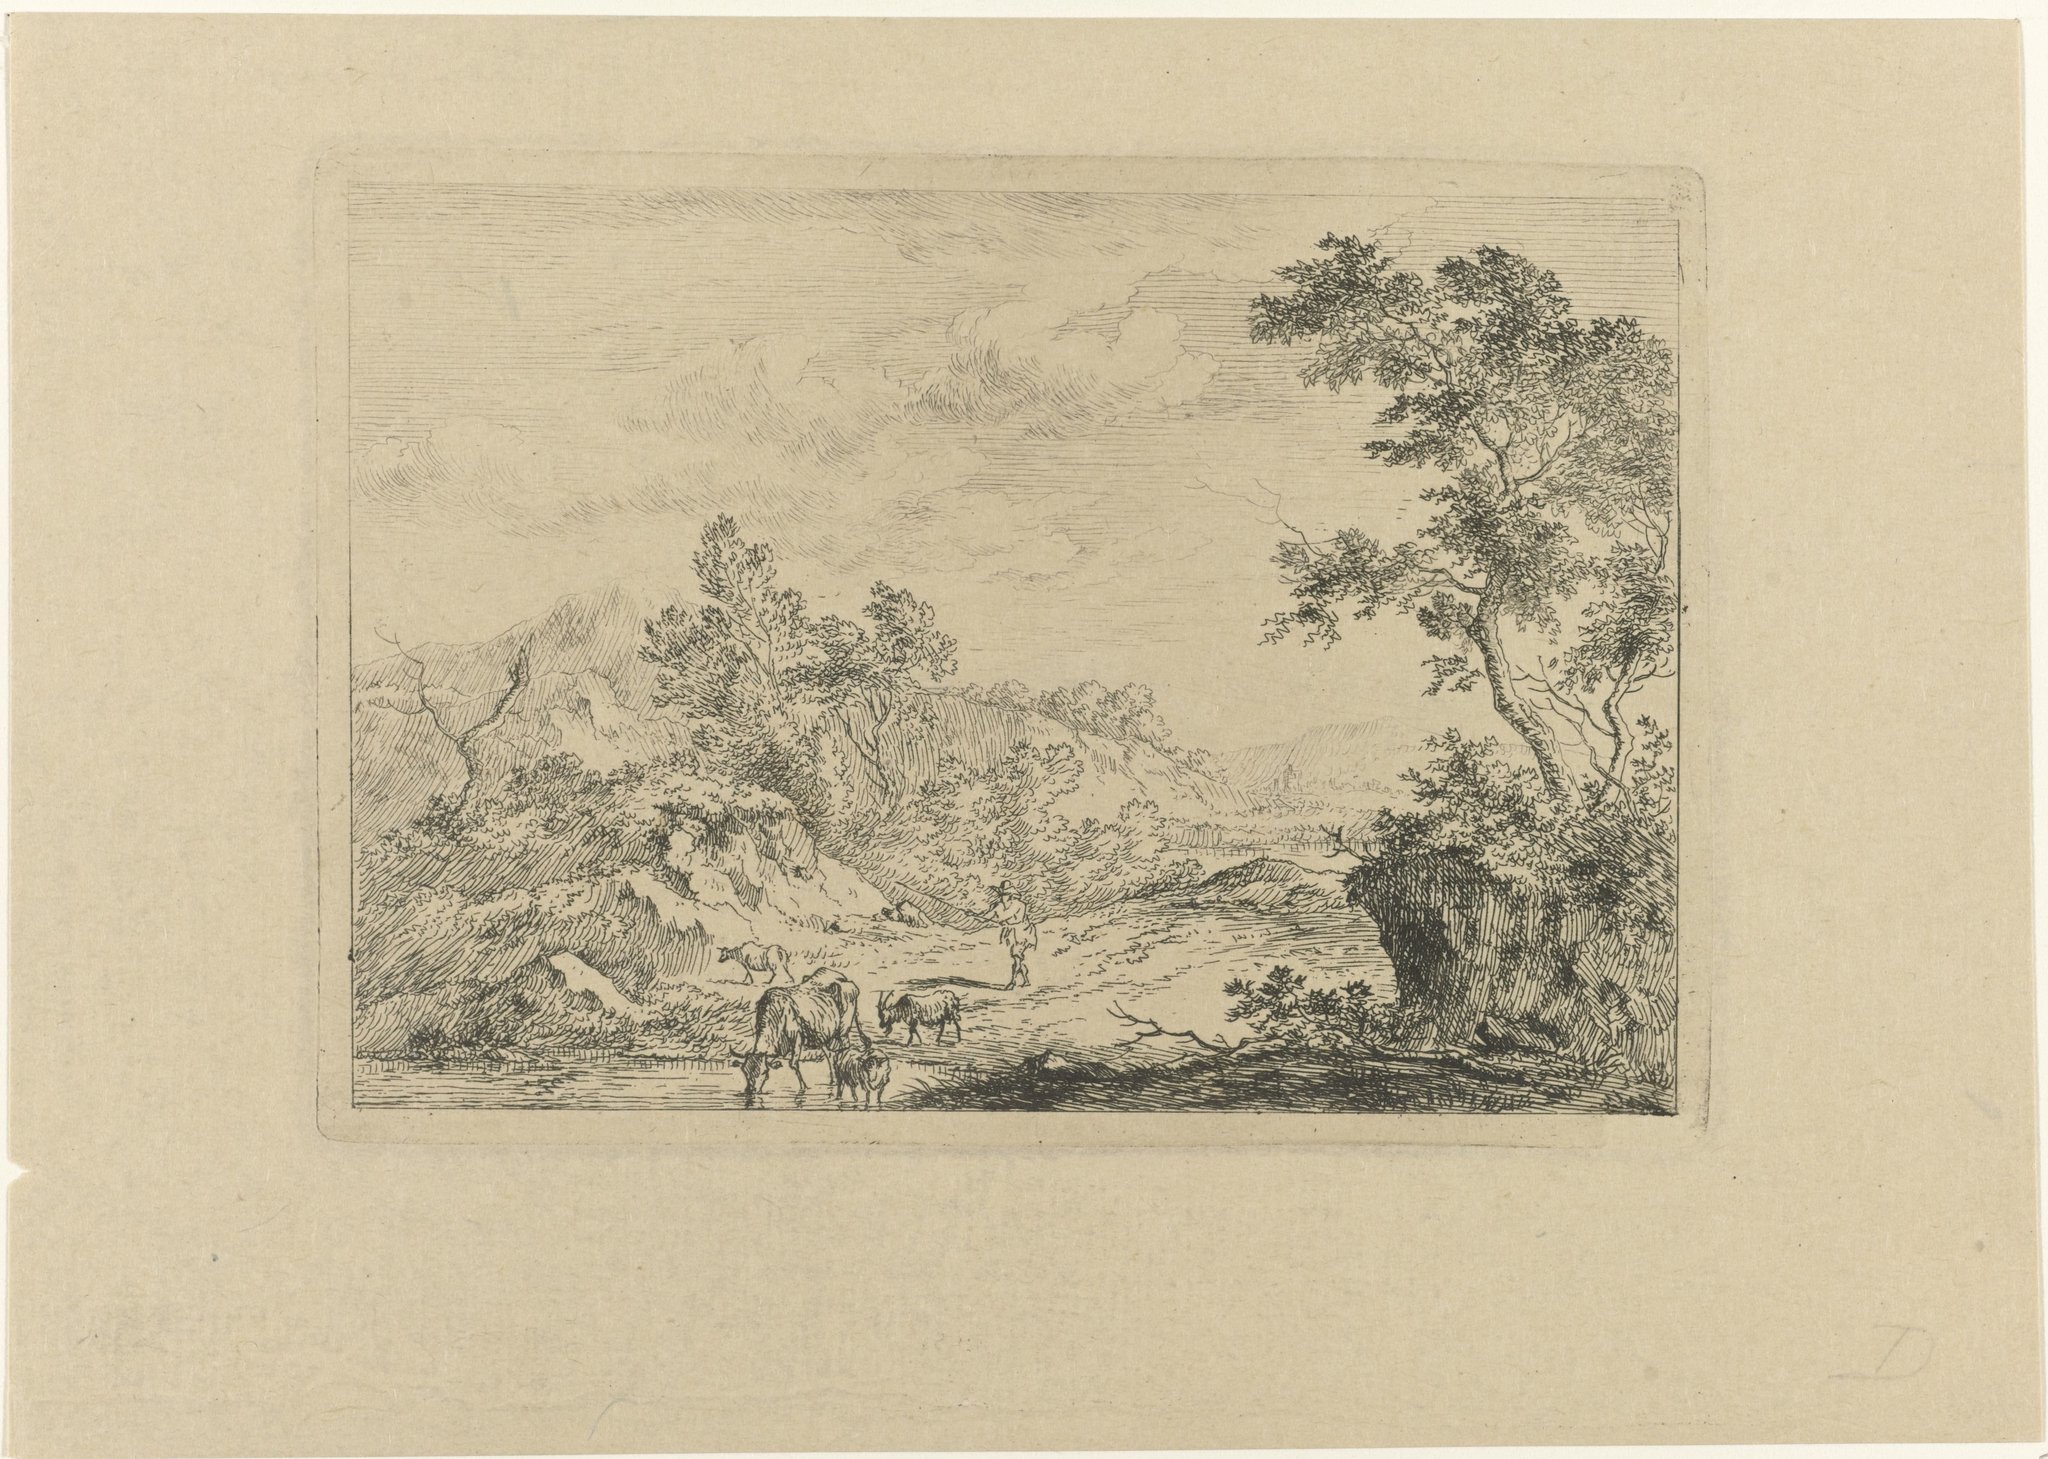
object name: print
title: Landschap met herder en vee bij beek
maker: johannes janson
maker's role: draughtsman, painter, print maker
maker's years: 1729-1784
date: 1761-1784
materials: paper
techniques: etching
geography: leiden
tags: herding, herdsman, herdswoman, shepherd, shepherdess, cowherd, etc., landscapes (+ landscape with figures, staffage)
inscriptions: collector's mark: Lugt 240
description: Heuvelachtig landschap met een herder, die zijn vee naar een beekje drijft om te drinken. Prent uit een serie met landschappen.